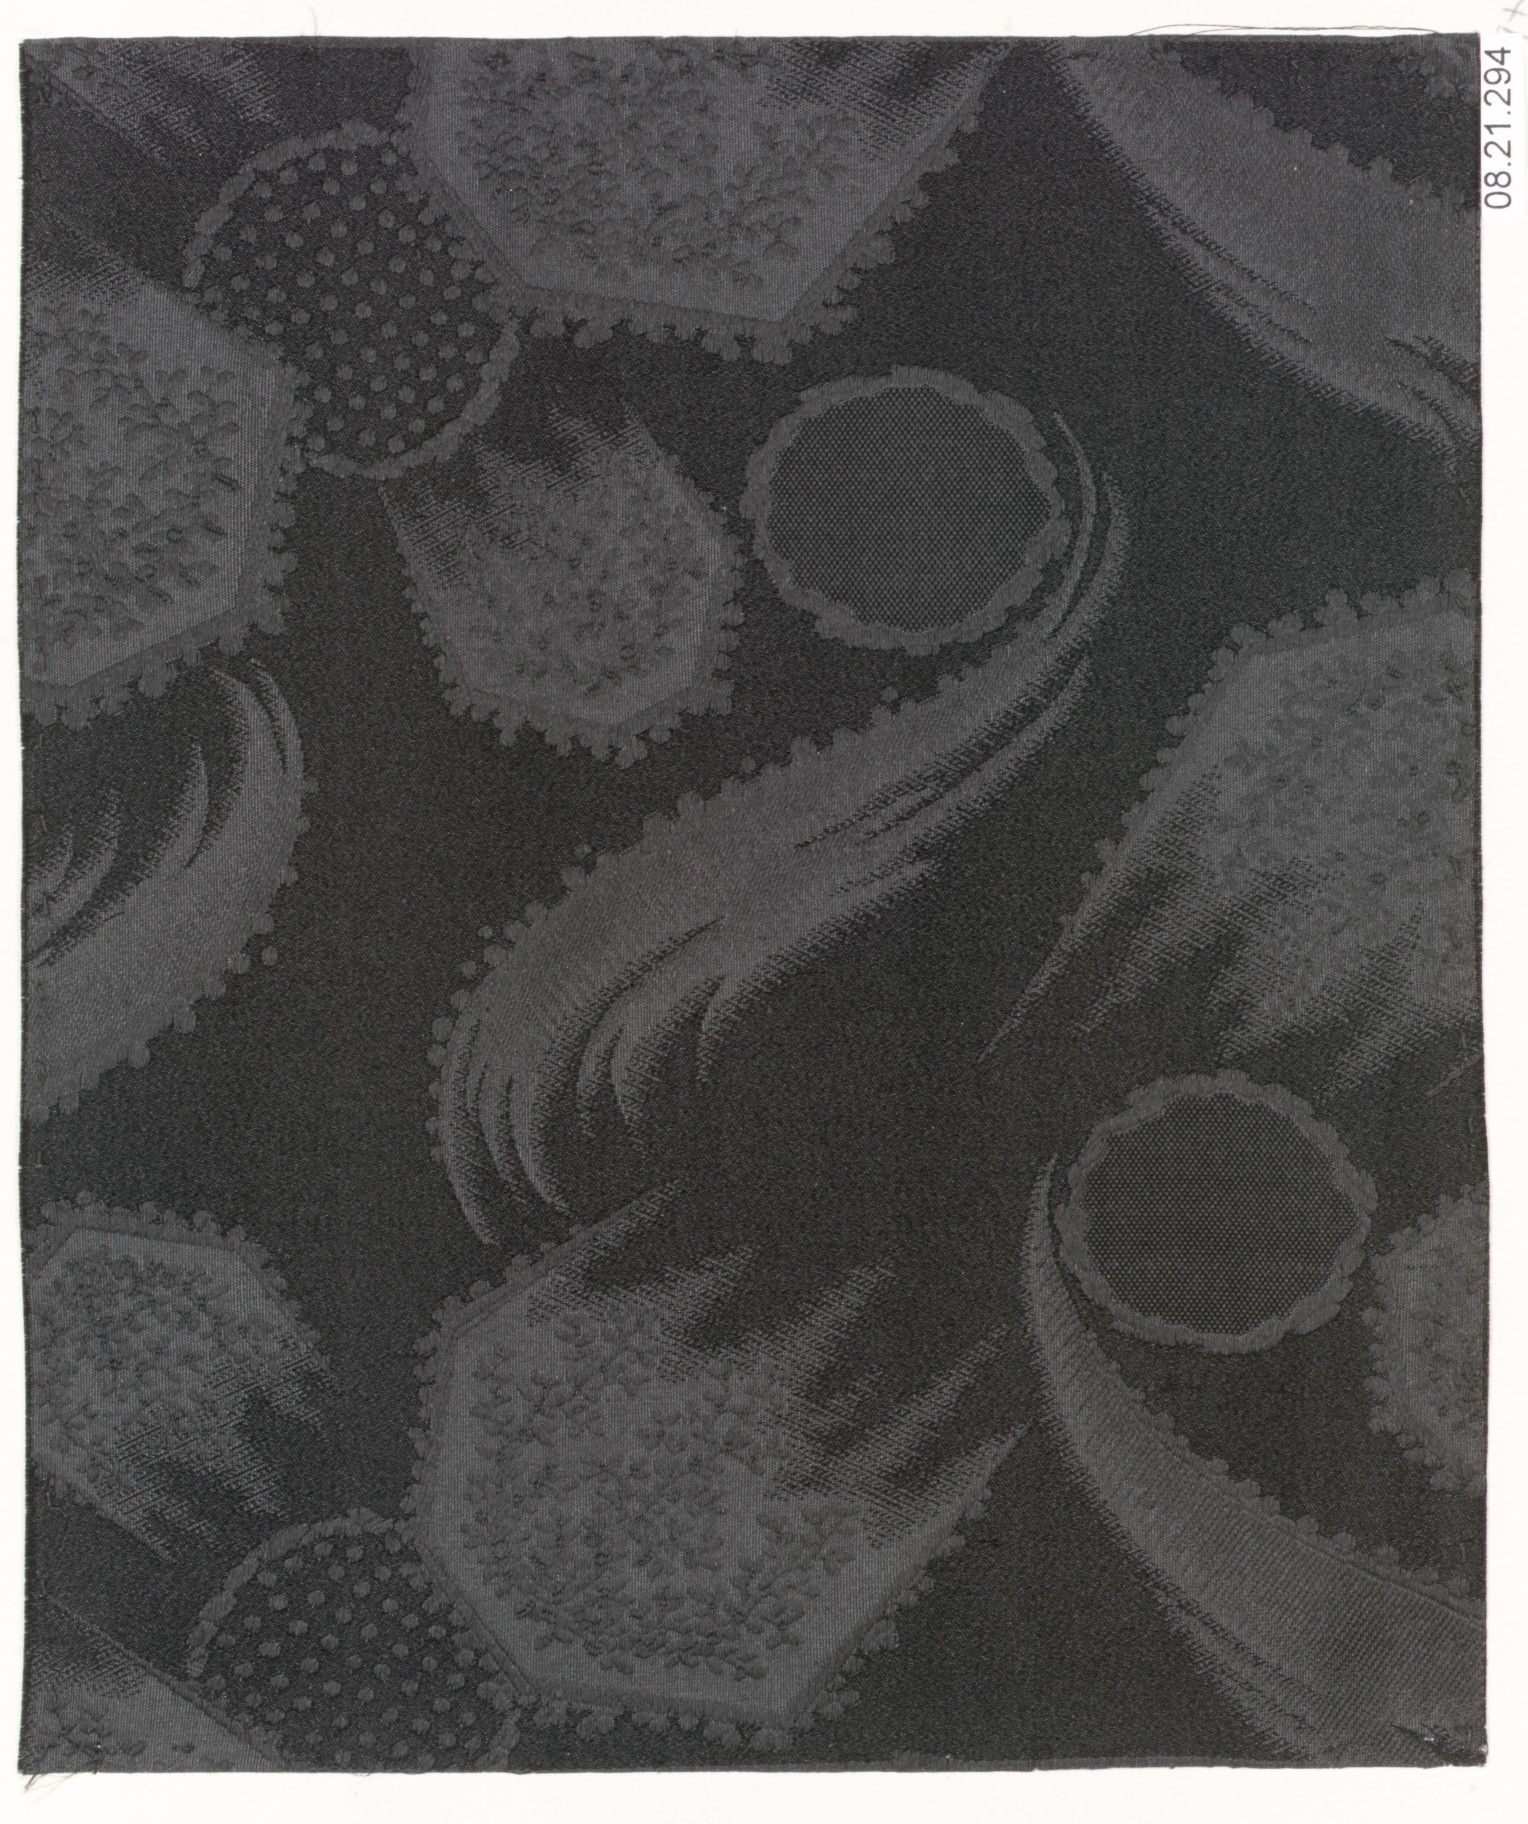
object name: textile sample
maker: Anonymous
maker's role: designer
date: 1900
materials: silk